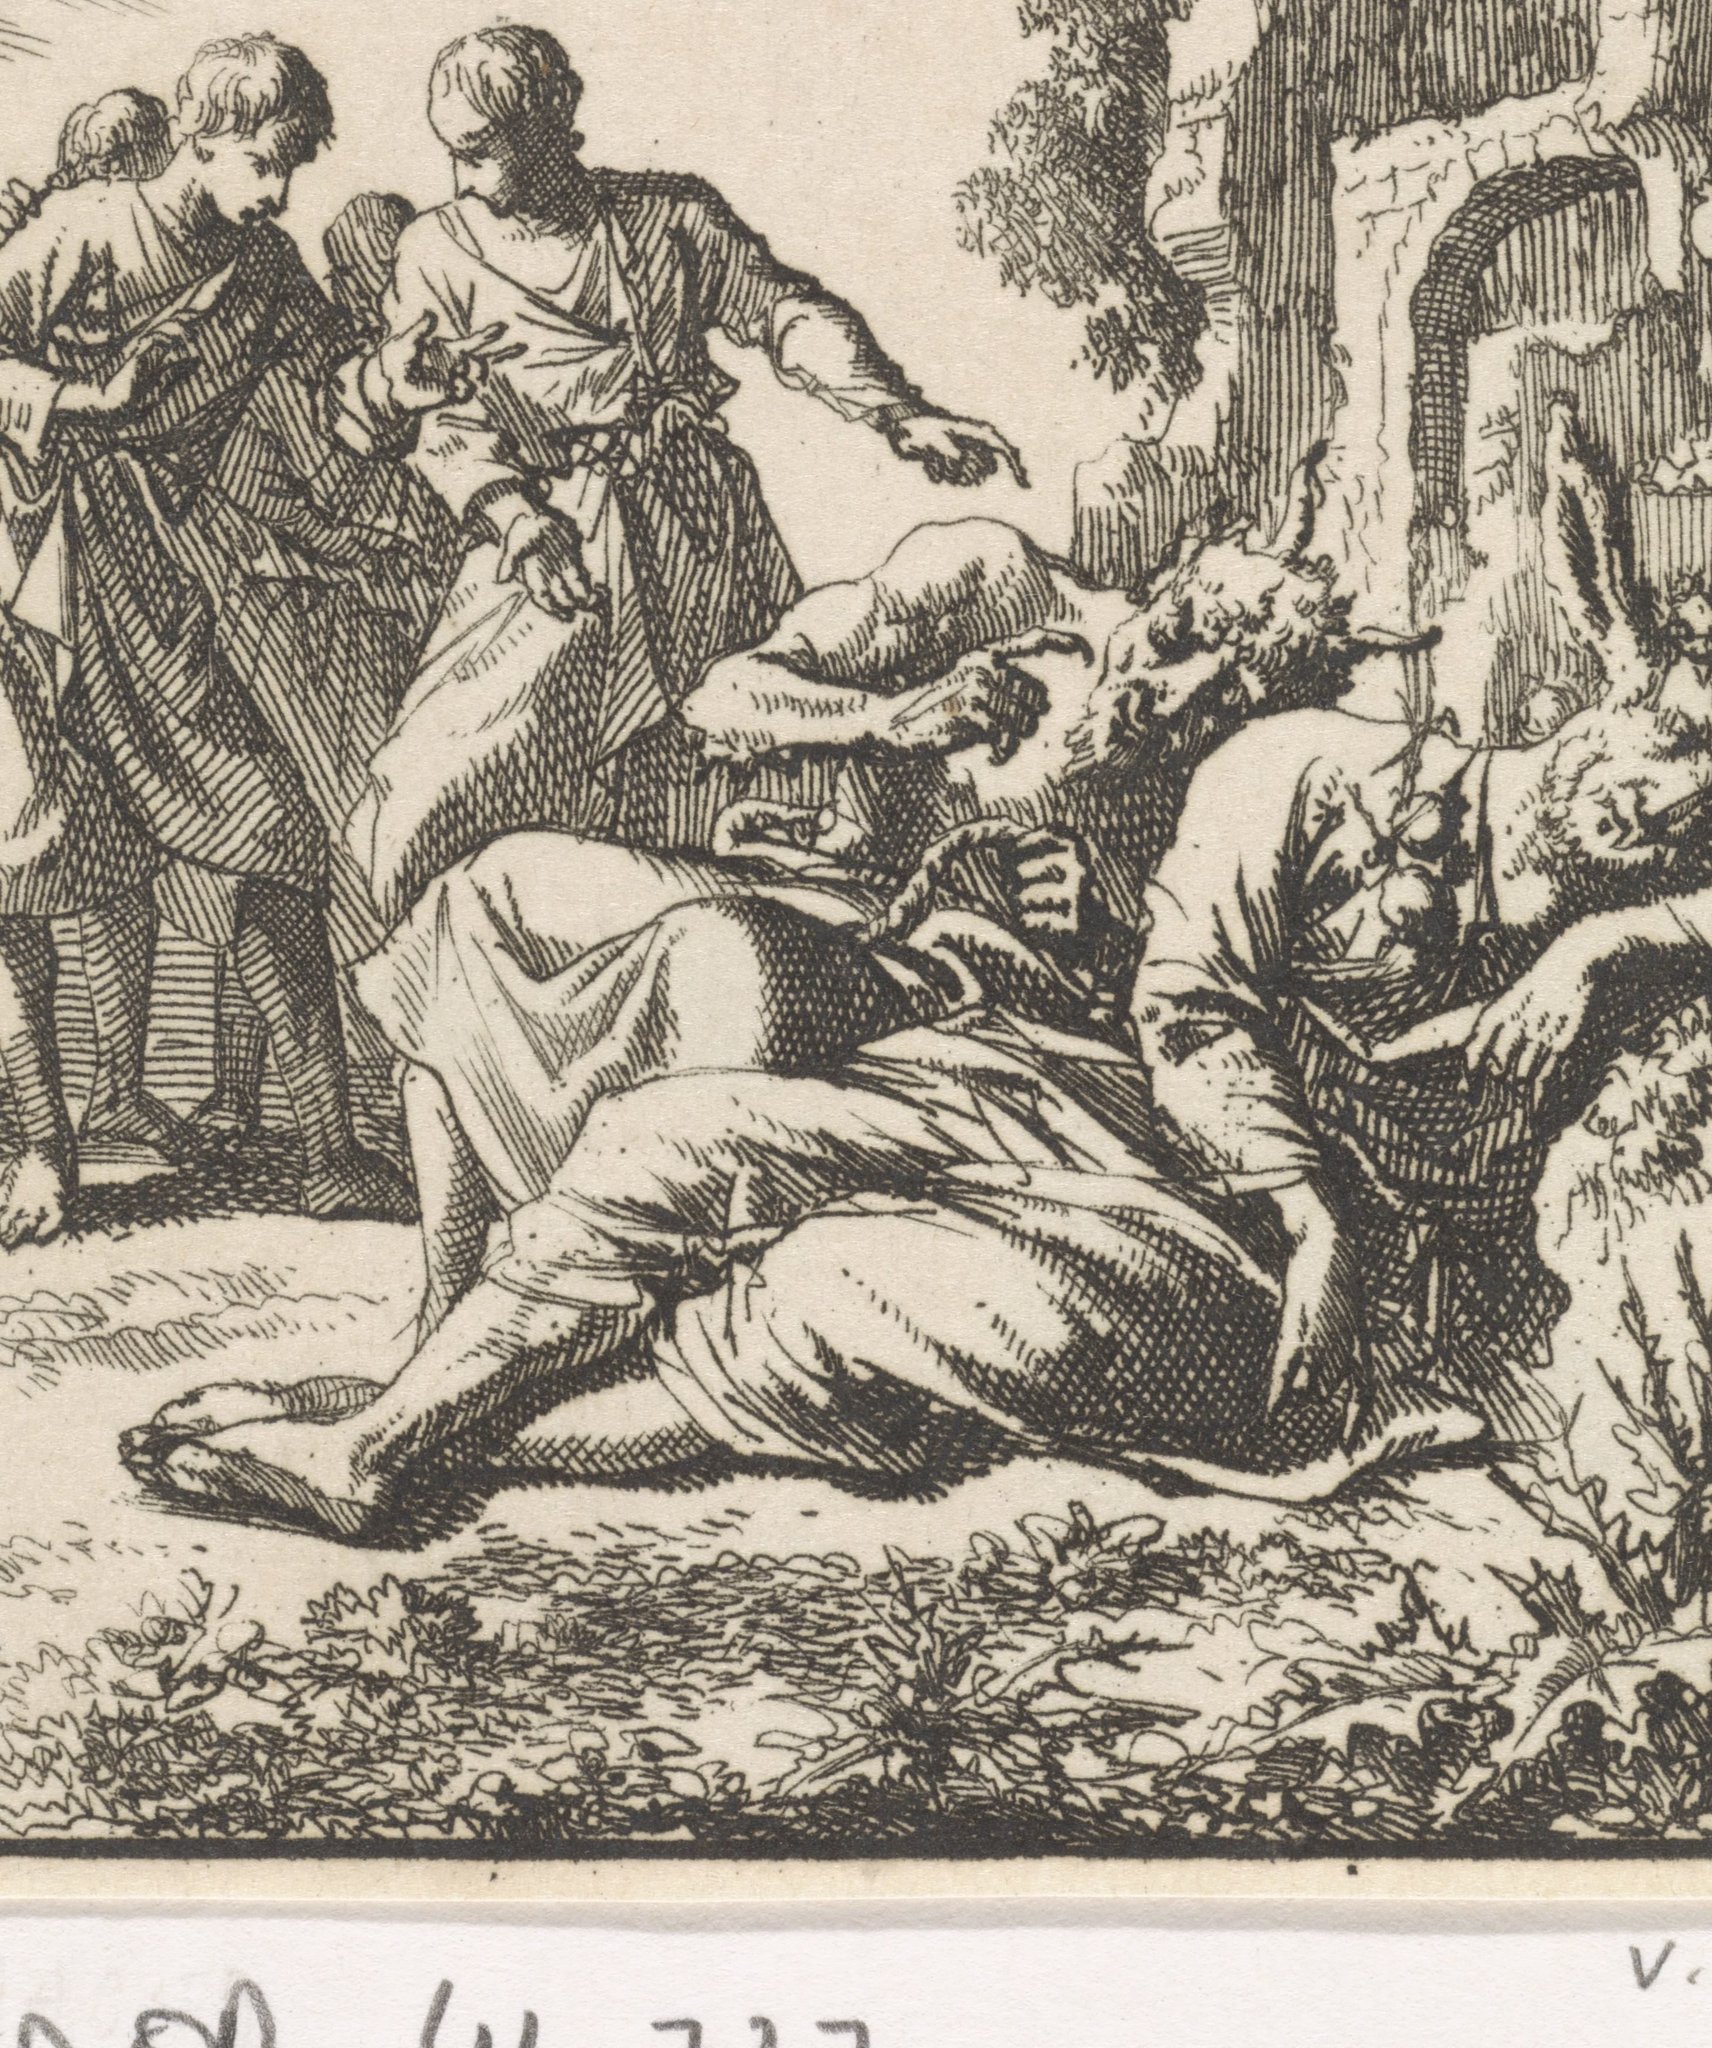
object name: print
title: Traagheid slapend naast de duivel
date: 1699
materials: paper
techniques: etching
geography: amsterdam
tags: sloth, indolence, 'acedia', 'desidia'; 'accidia' (ripa) ~ personification of one of the seven deadly sins, devil(s) and demons, flowers: poppy, ruin of a dwelling, house, castle, etc.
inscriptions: collector's mark: Lugt 2228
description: De personificatie Traagheid, met ezelsoren, ligt te slapen bij een papaverbloem. De duivel ligt naast hem. Op de achtergrond een ruïne en enkele jongelingen die naar de duivel wijzen.